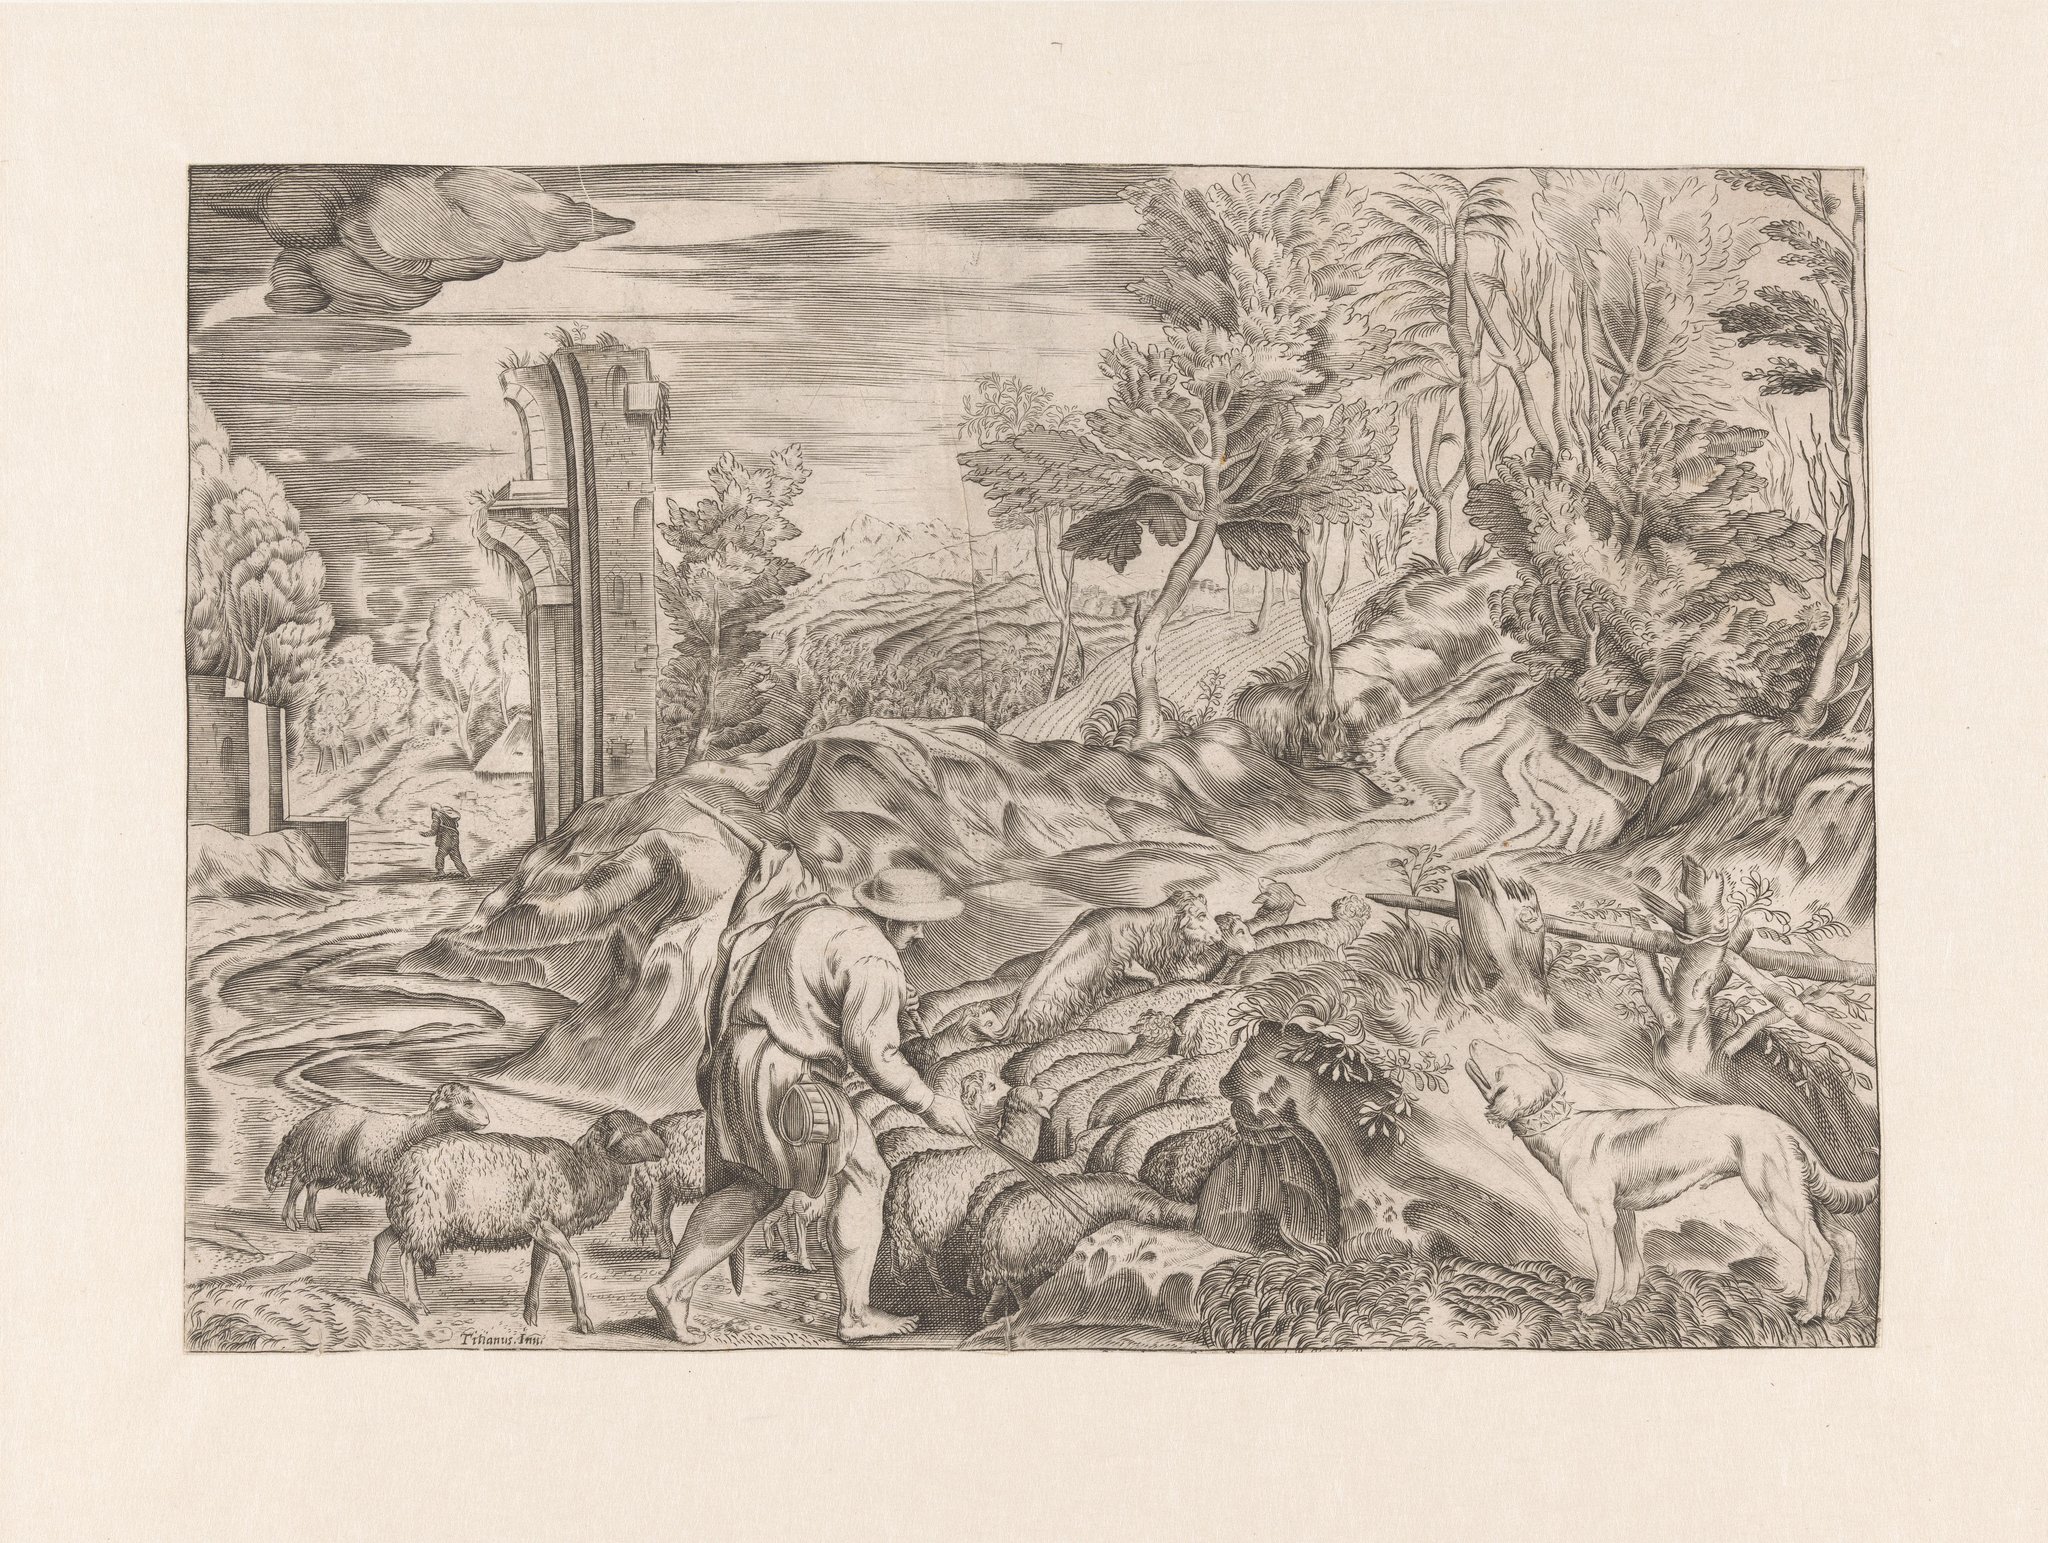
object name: print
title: Herder met kudde schapen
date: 1498-1626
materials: paper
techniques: engraving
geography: italy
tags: landscape with ruins, herd, flock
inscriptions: collector's mark: Lugt 2760, collector's mark: Lugt 2228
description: Een jonge herder met zomerhoed leidt zijn kudde schapen op een heuvel. Zijn hond kijkt toe op de voorgrond rechts. Op de achtergrond rechts een bosrijke heuvel en links een antieke ruïne en een wandelaar.